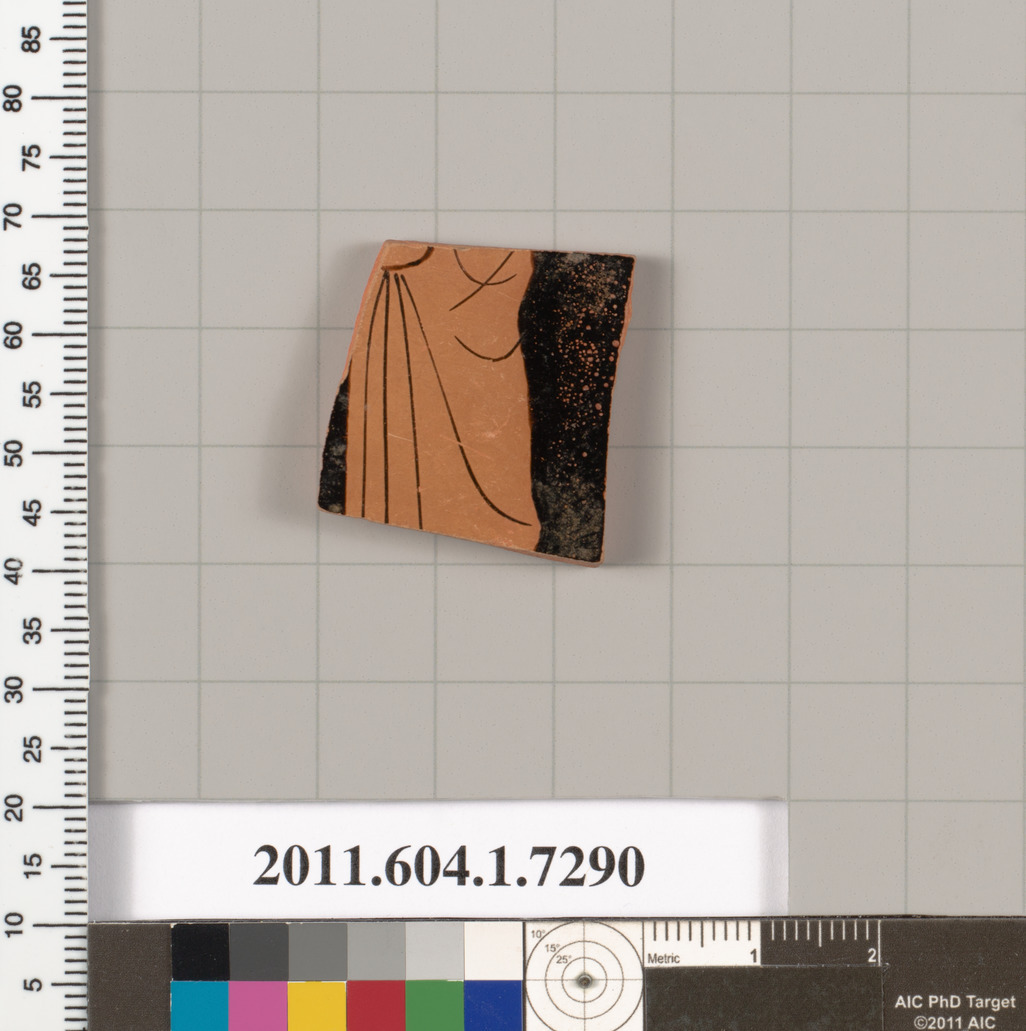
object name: kylix fragment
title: Terracotta fragment of a kylix (drinking cup)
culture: greek, attic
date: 500-480 BCE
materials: terracotta